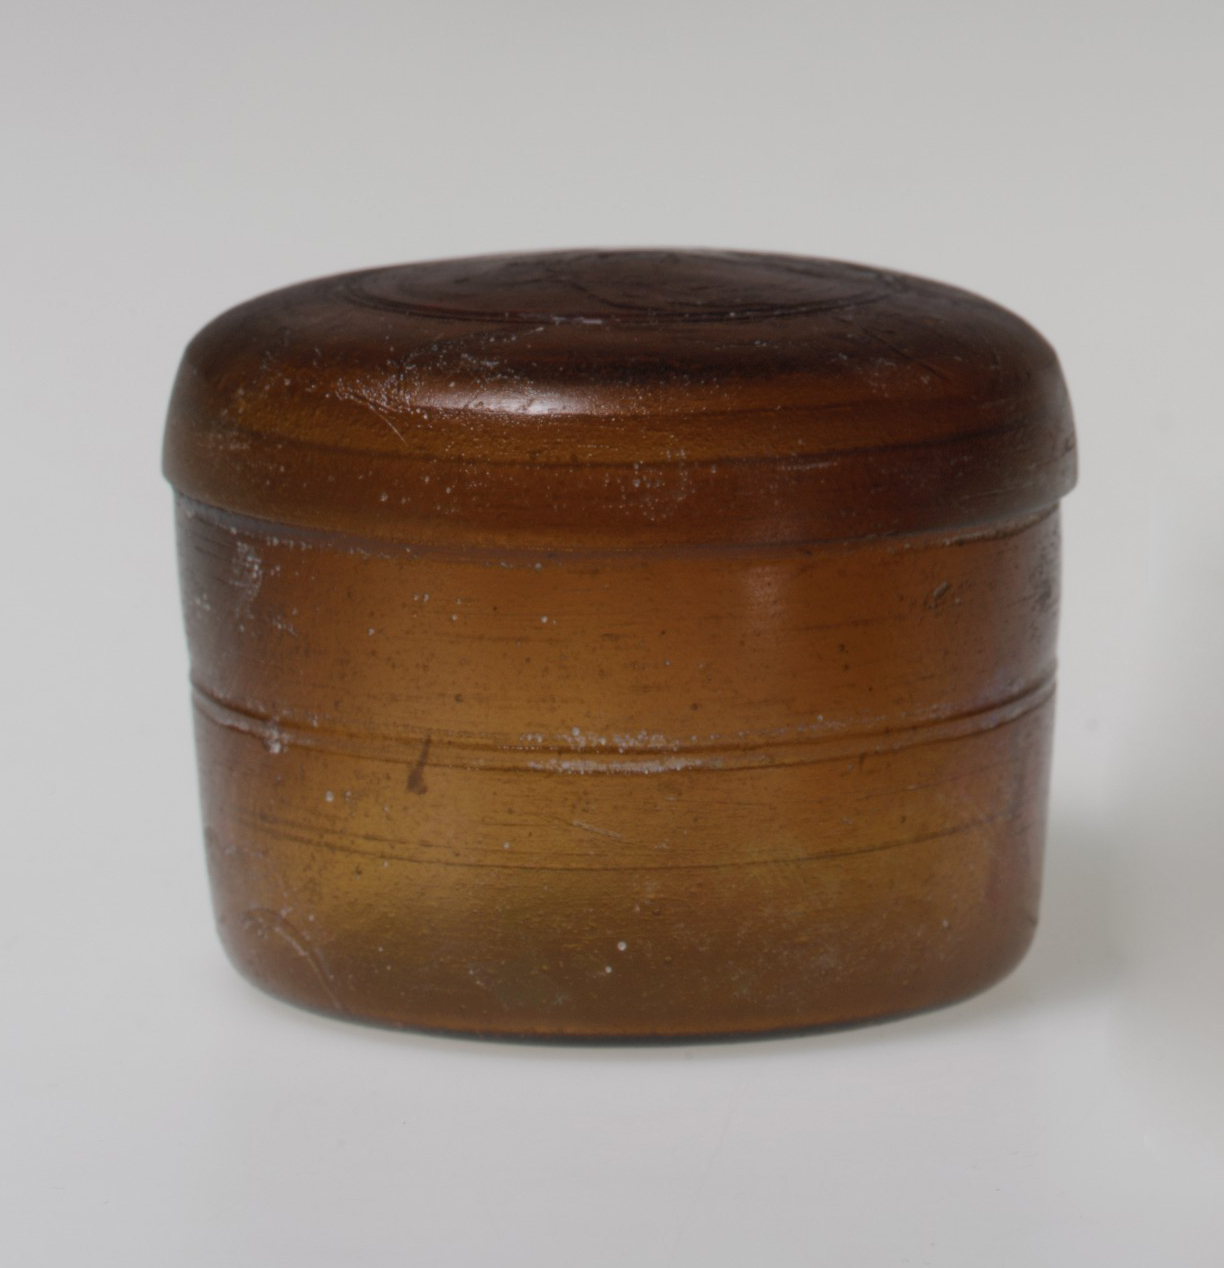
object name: pyxis with lid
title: Glass pyxis (box with lid)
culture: roman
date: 67-100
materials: glass